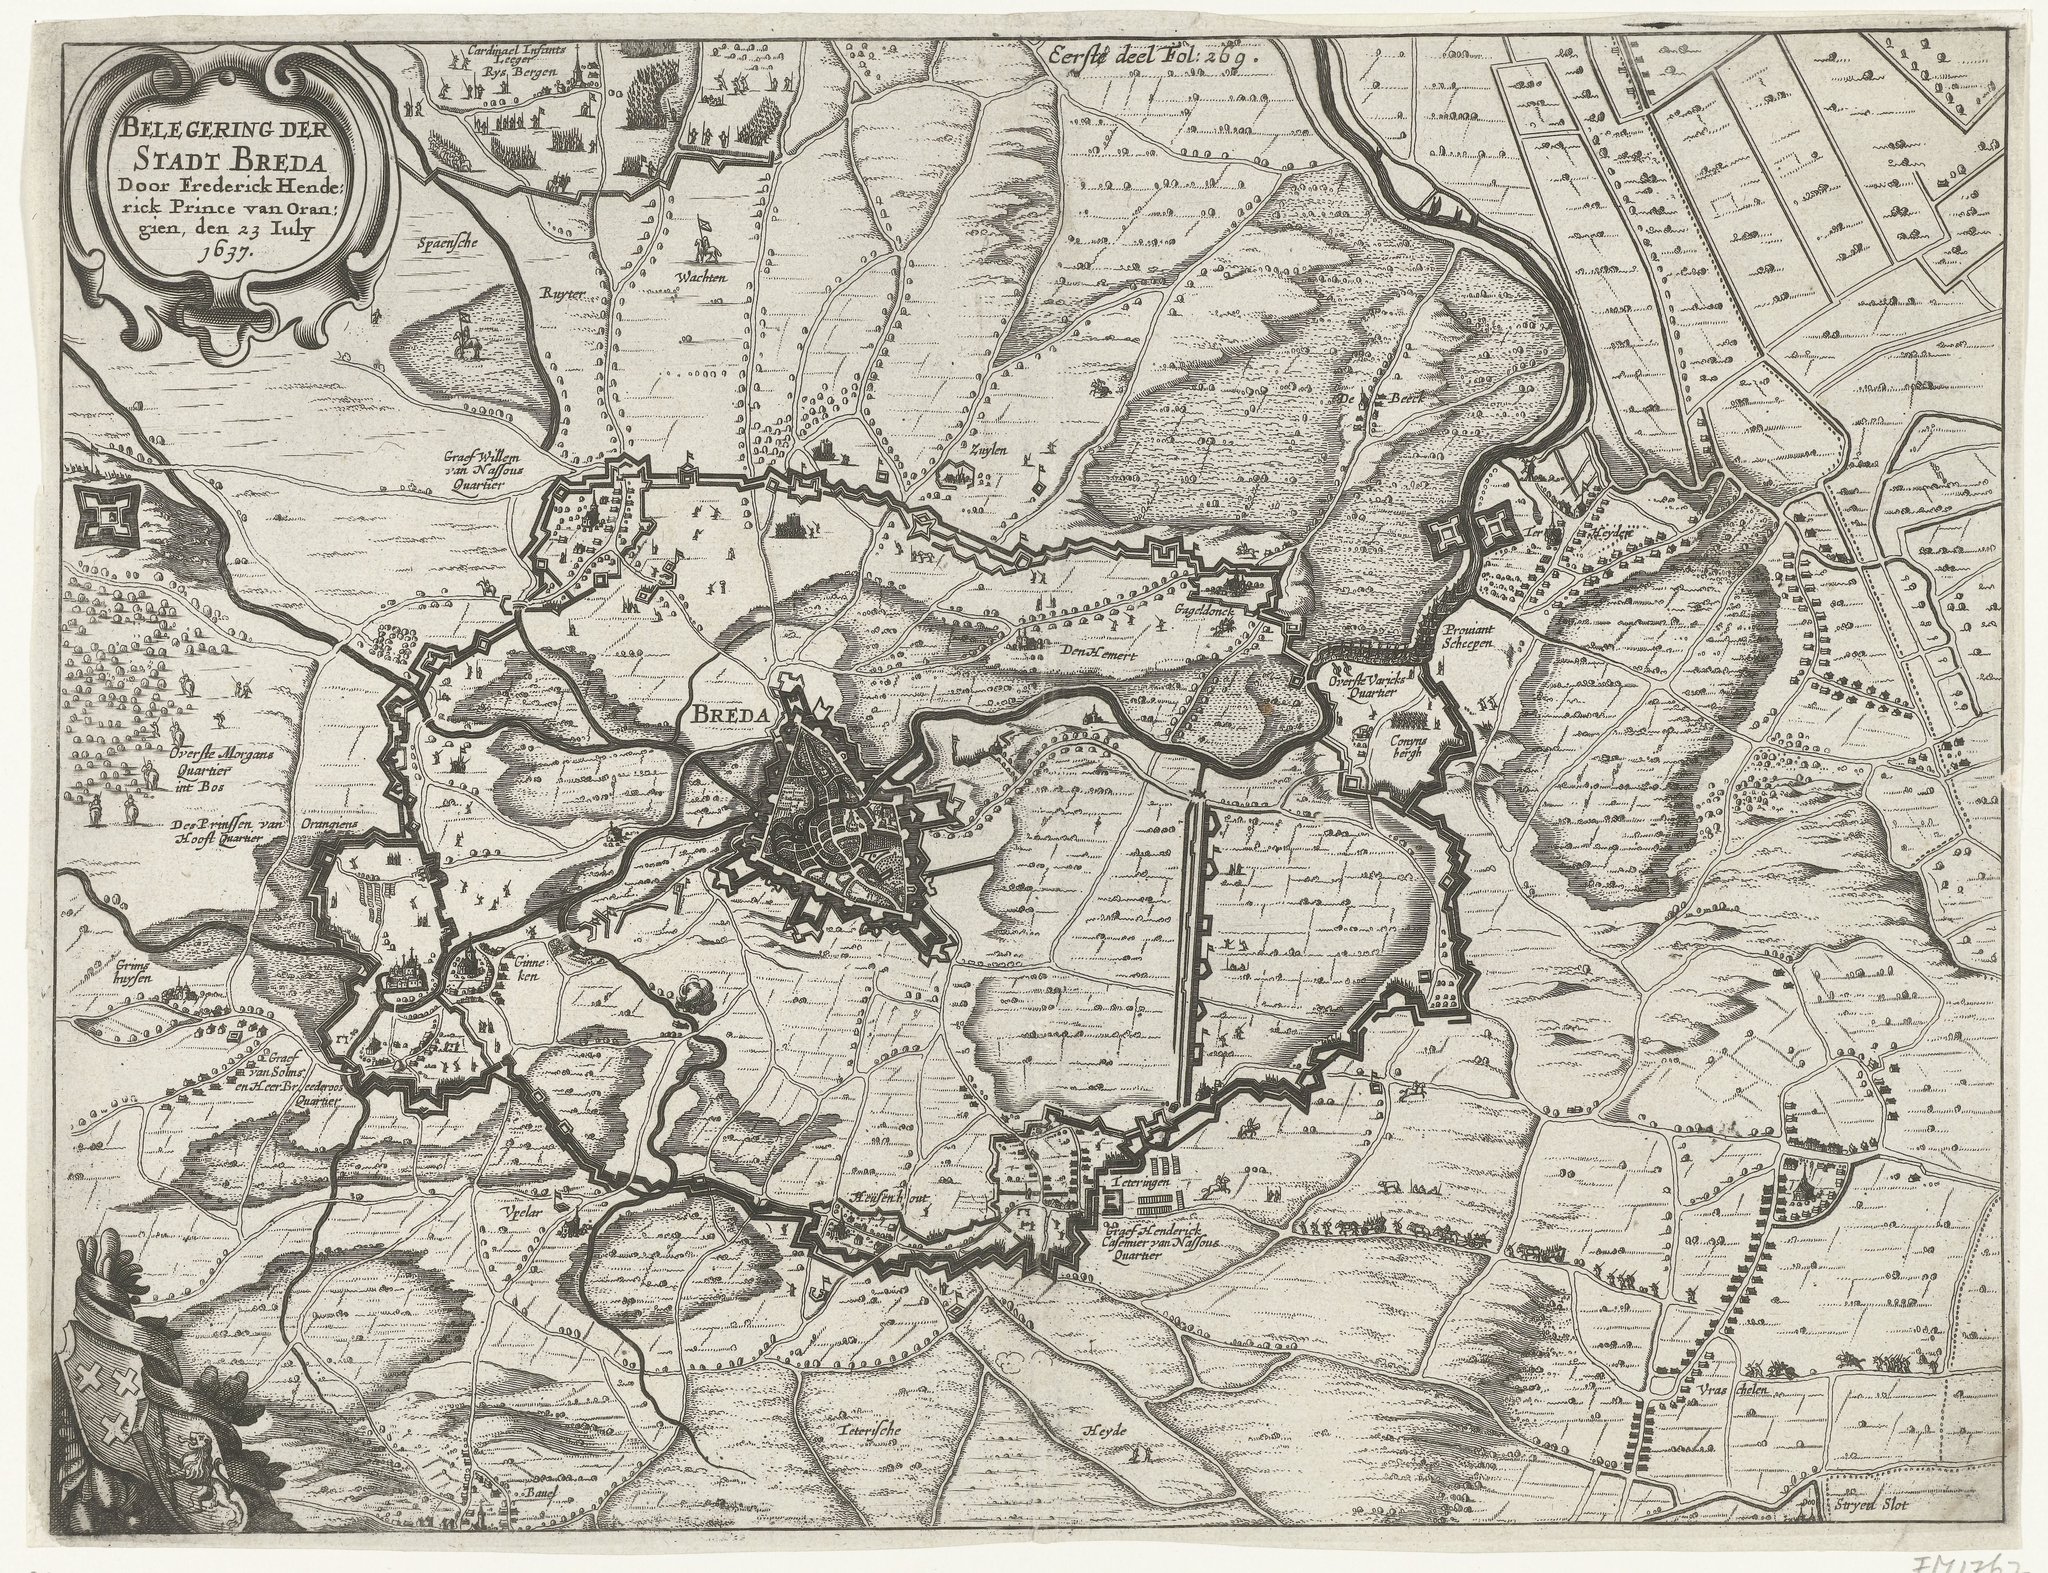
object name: history print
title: Belegering der Stadt Breda Door Frederick Henderick Prince van Orangien, den 23 July 1637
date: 1649-1651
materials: paper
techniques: etching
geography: northern netherlands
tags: delft, the hague, frederick henry (prince of orange), maps of separate countries or regions, siege, position war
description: Belegering en verovering van Breda door het Staatse leger onder Frederik Hendrik, 23 juli - 10 oktober 1637. Kaart van de stad en omgeving. Linksonder de wapens van Breda en Geertruidenberg. Gemerkt middenboven: Eerste deel Fol: 269.